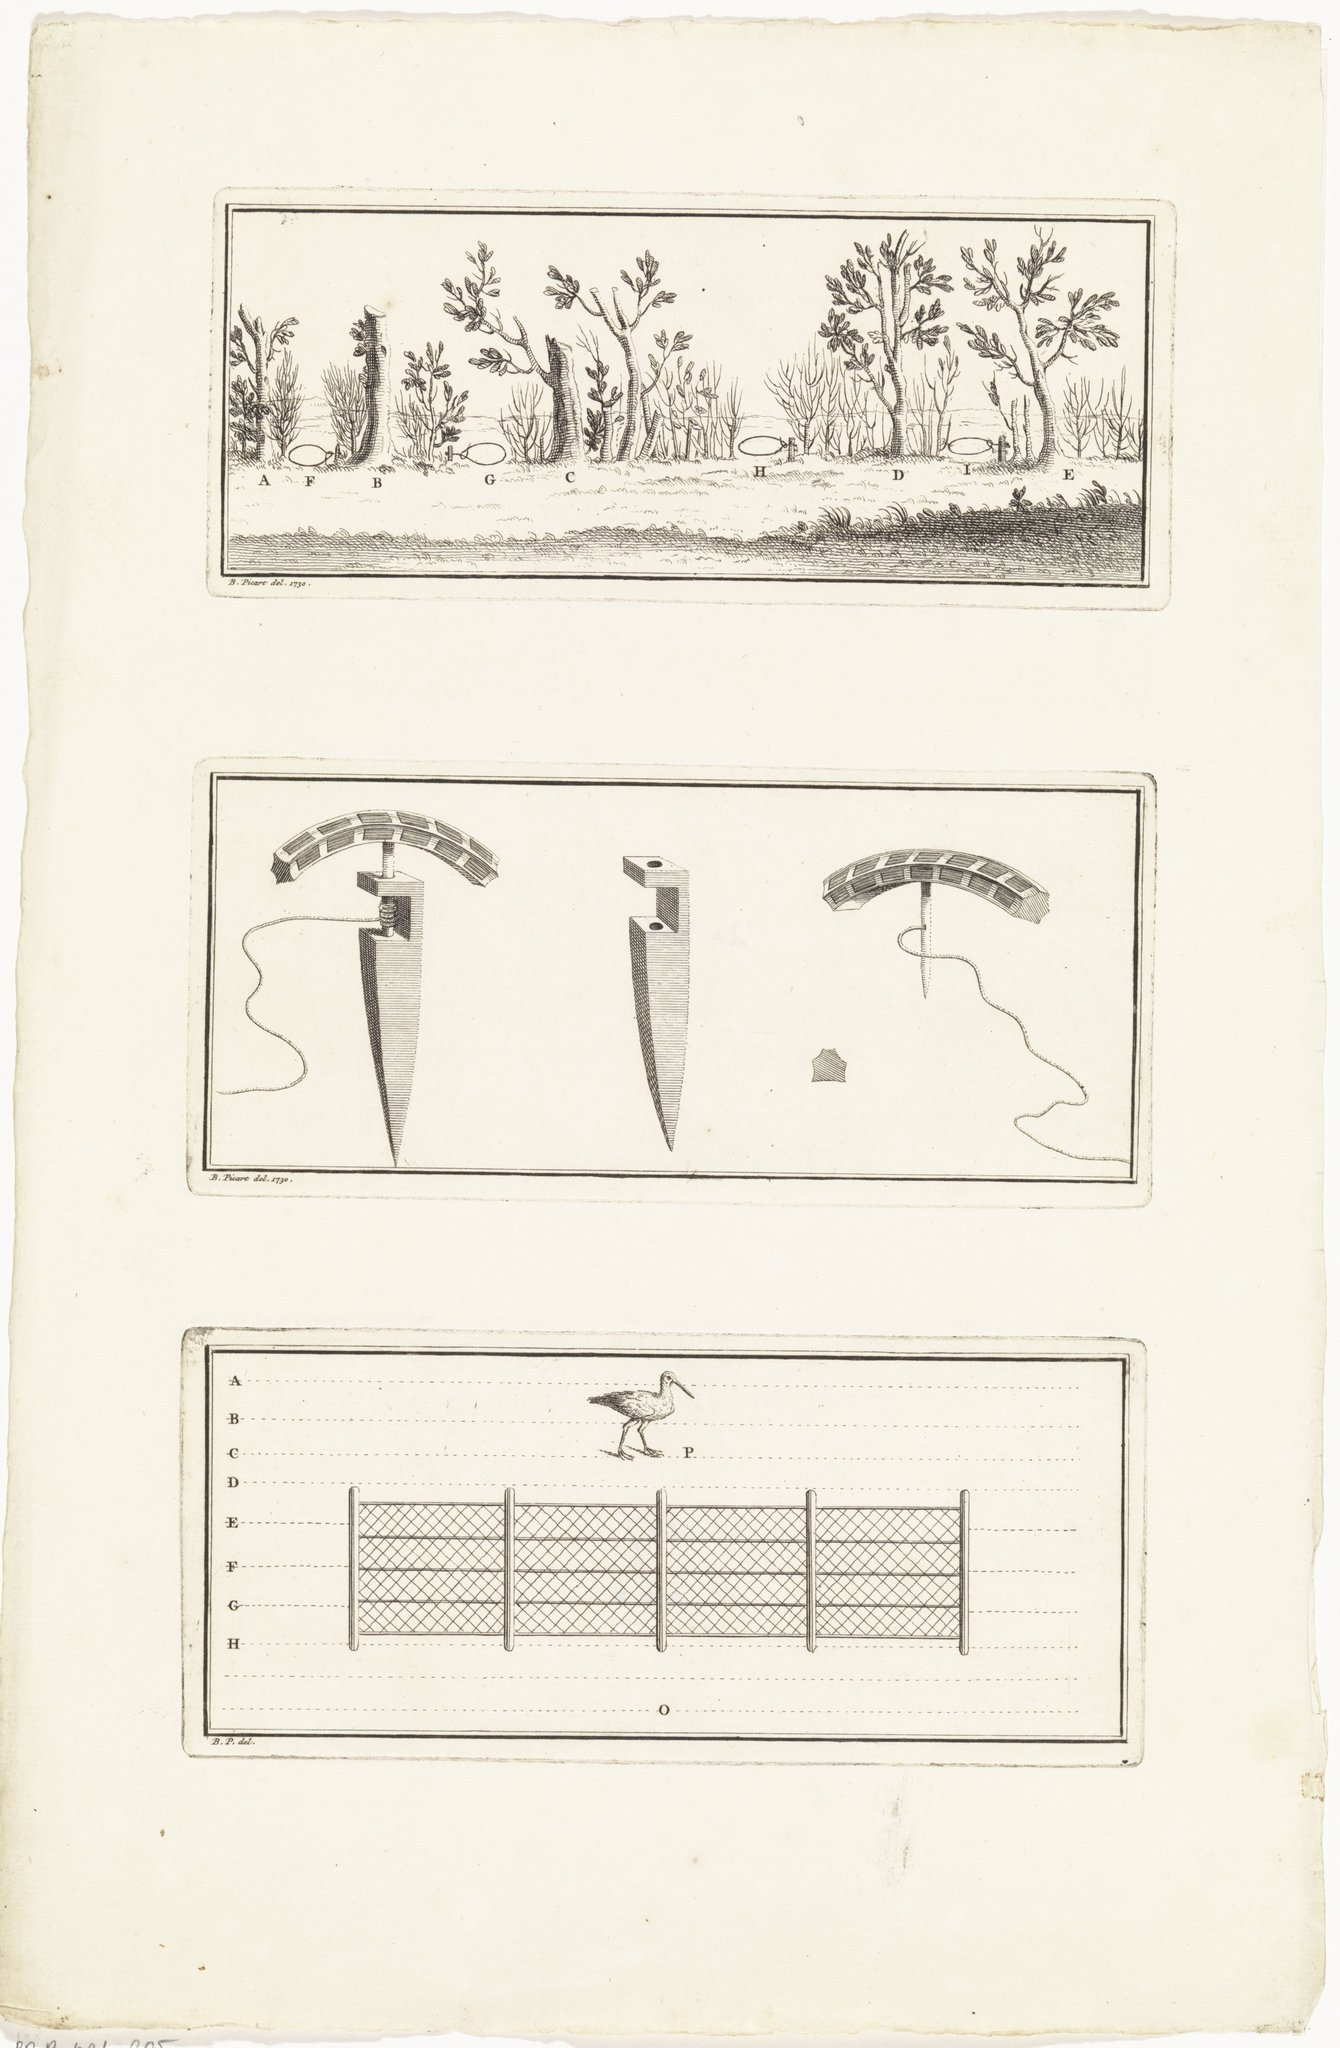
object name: book illustration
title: Constructies voor dierenvallen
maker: bernard picart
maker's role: draughtsman, print maker, publisher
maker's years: 1673-1733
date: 1730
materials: paper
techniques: etching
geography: amsterdam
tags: bird hunting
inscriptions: collector's mark: Lugt 2233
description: Prenten bedoeld voor: Chomel, Noel. Dictionnaire oeconomique, contenant divers moïens d'augmenter son bien, et de conserver sa santé. Amsterdam: Johannes Covens en Cornelis Mortier, 1732.